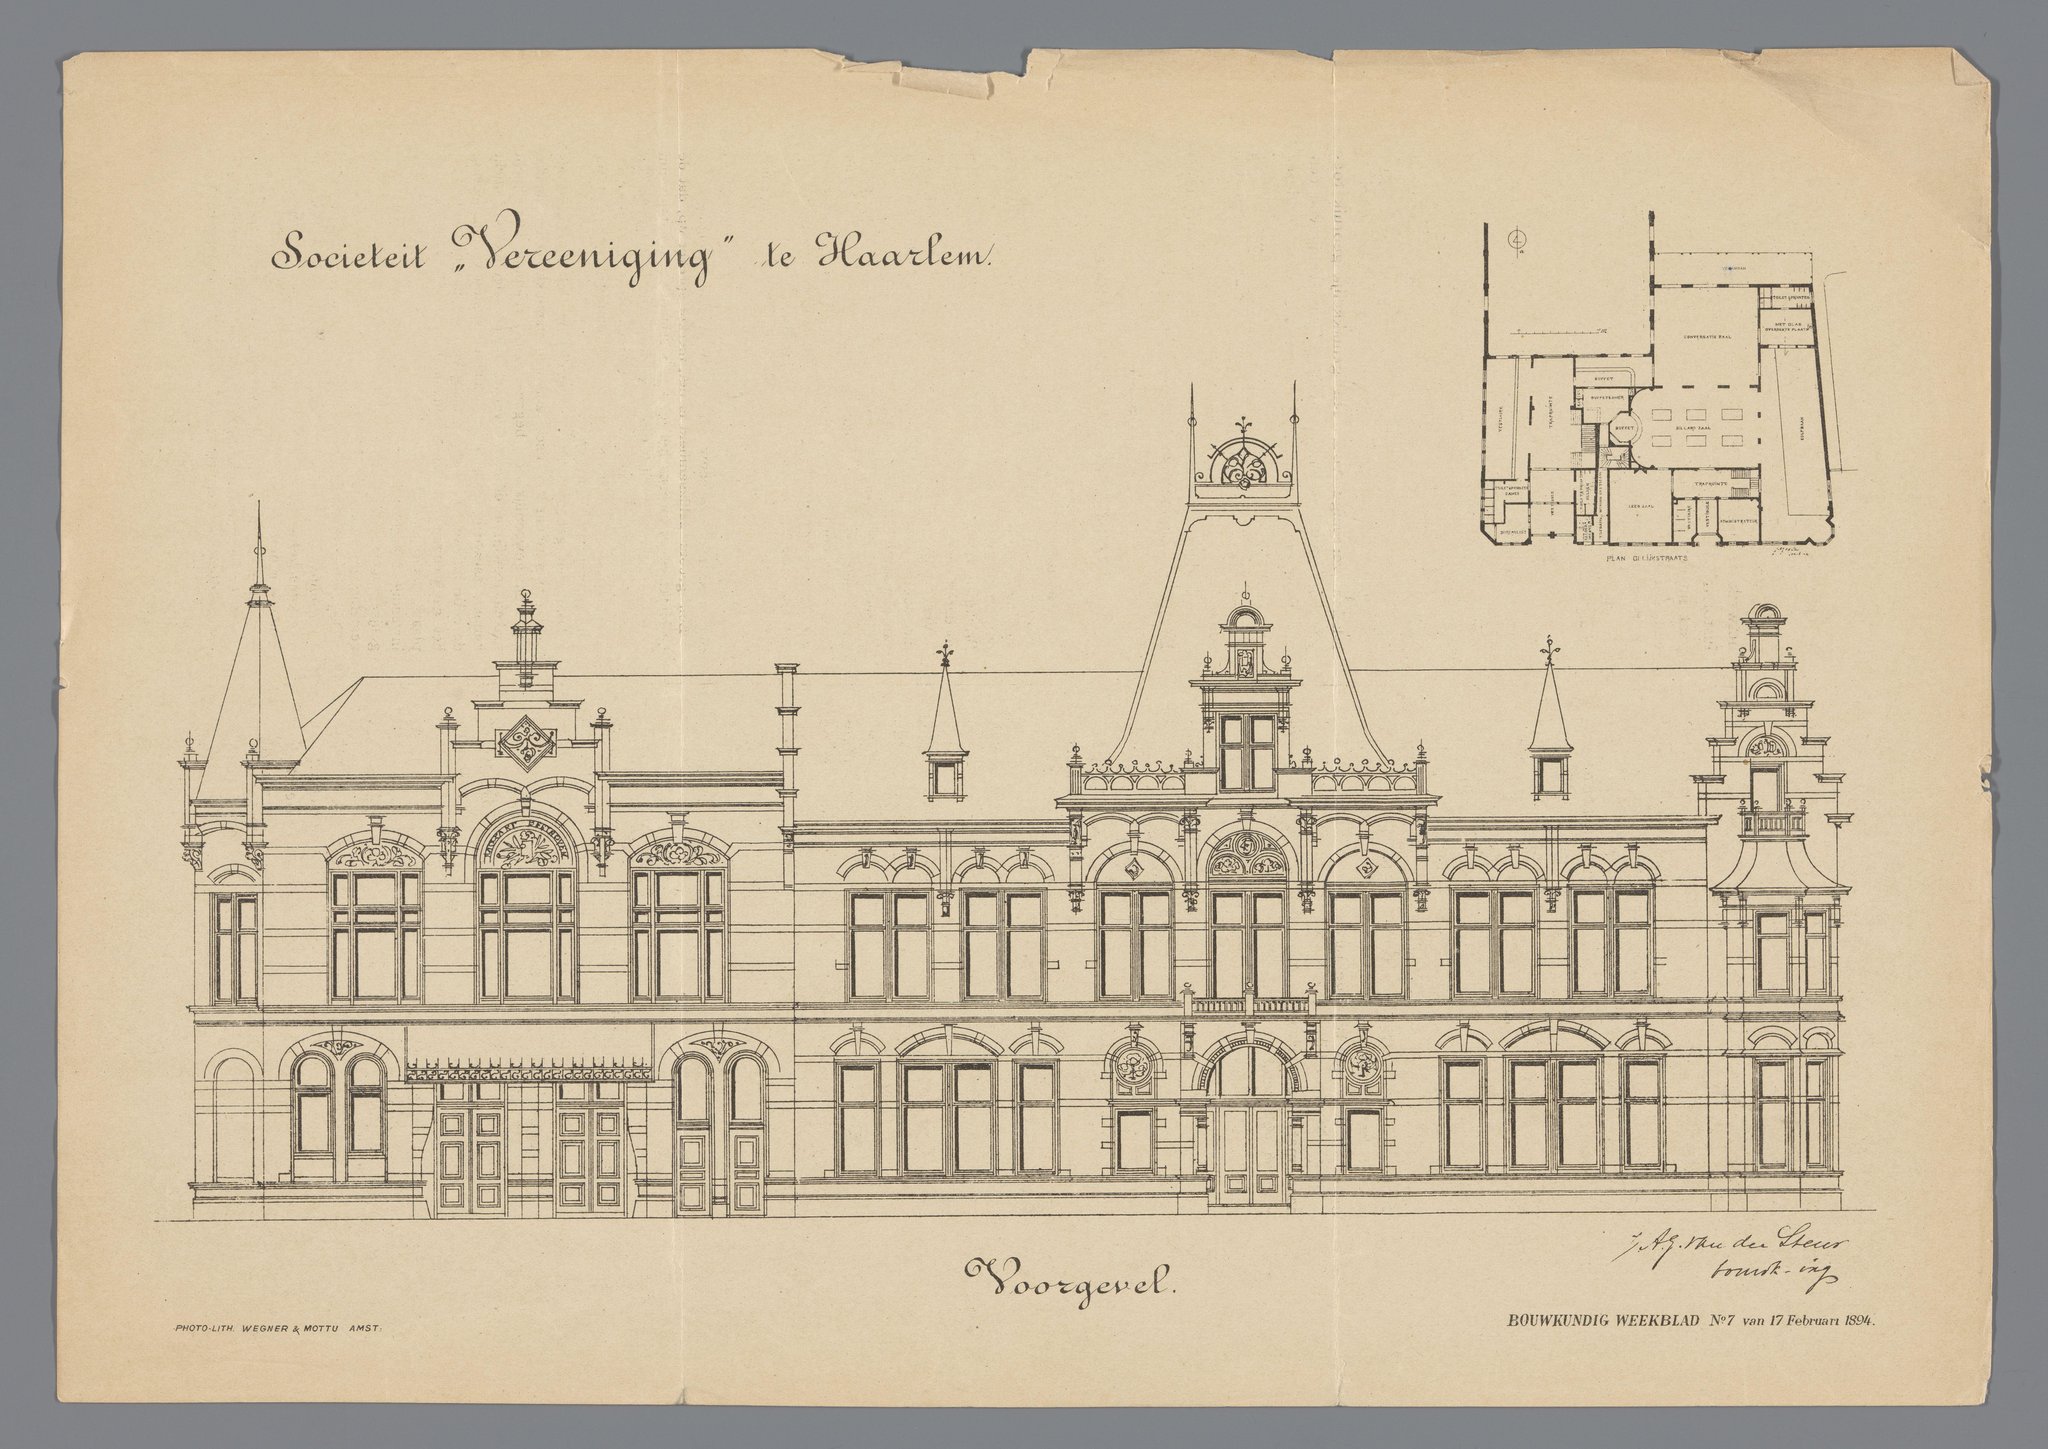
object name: book illustration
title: Gevel en ontwerp van Sociëteit Vereeniging in Haarlem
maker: Anonymous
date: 1894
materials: paper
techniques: photolithography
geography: amsterdam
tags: edifice, e.g.: public building, department store, haarlem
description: Prent uit: Bouwkundig weekblad; Orgaan van de Maatschappij tot Bevordering der Bouwkunst. Den Haag: Mouton, 1881-1927, 14e jaargang (1894), nr. 7.